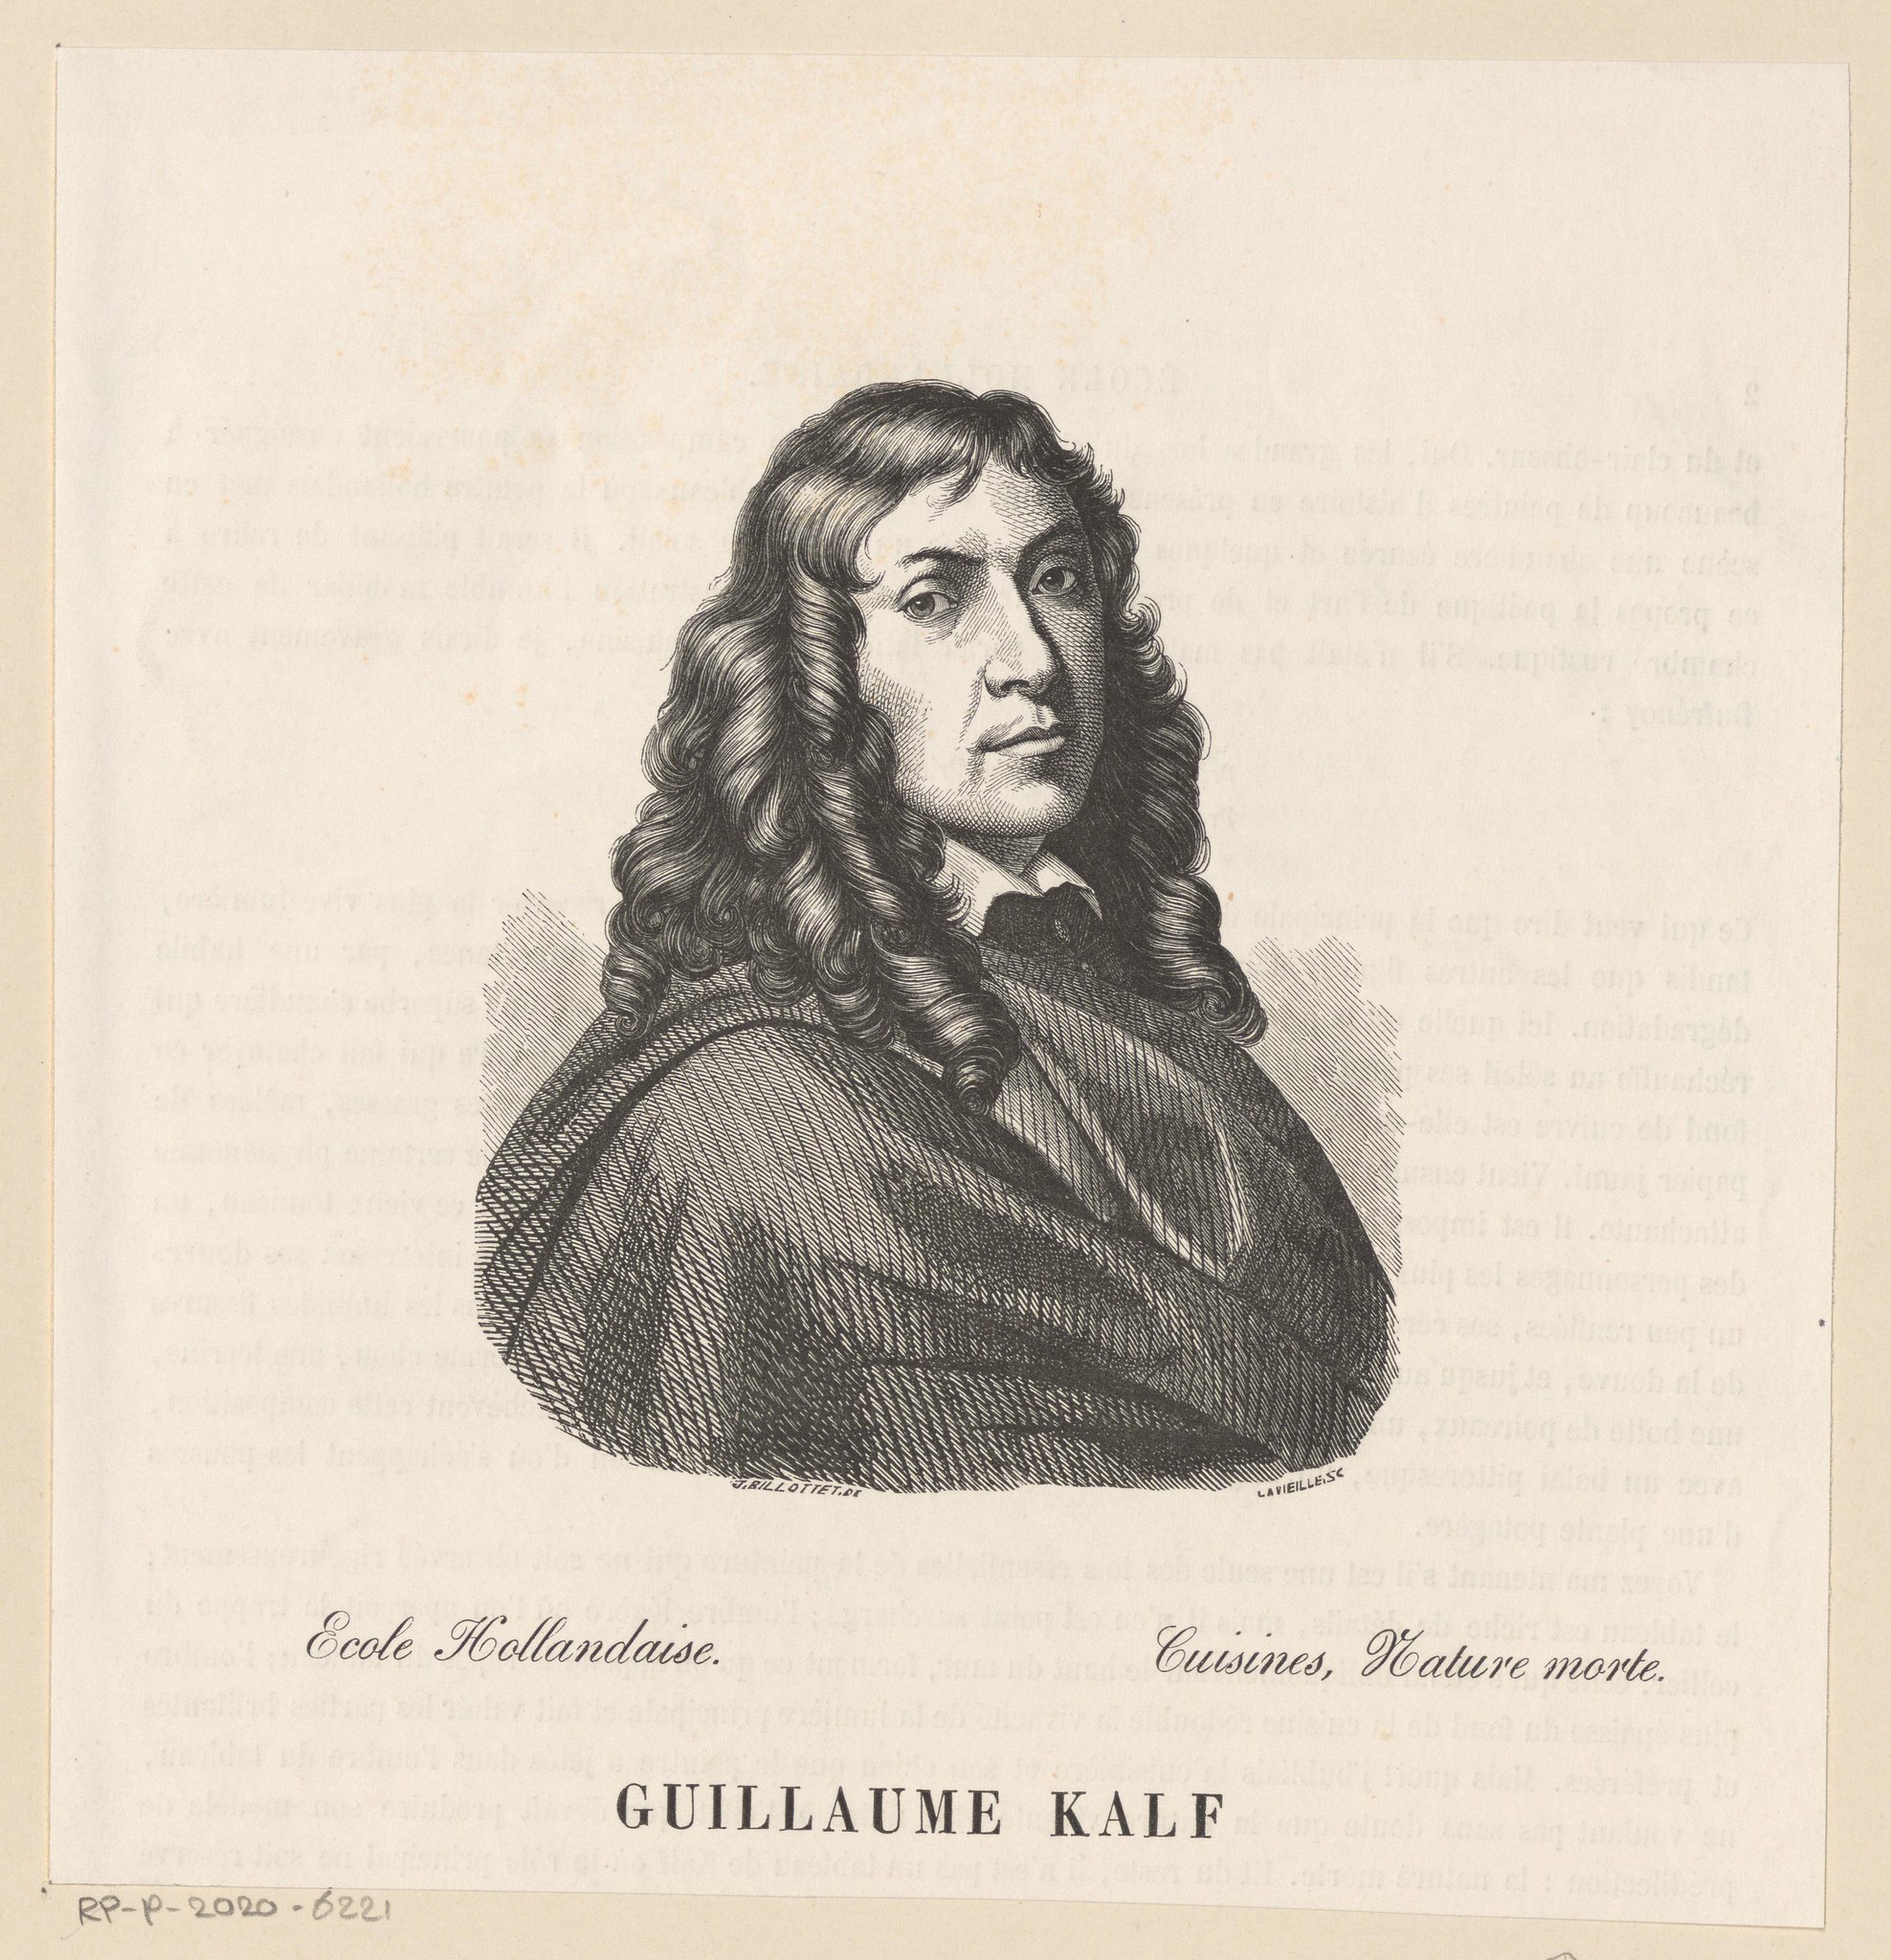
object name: print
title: Portret van Willem Kalf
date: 1861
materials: paper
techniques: letterpress printing, engraving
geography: paris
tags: amsterdam, painter, draughtsman, willem kalf, historical persons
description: Prent uit: Blanc, Charles. Histoire des peintres de toutes les écoles. Parijs: veuve Jules Renouard, 1861.